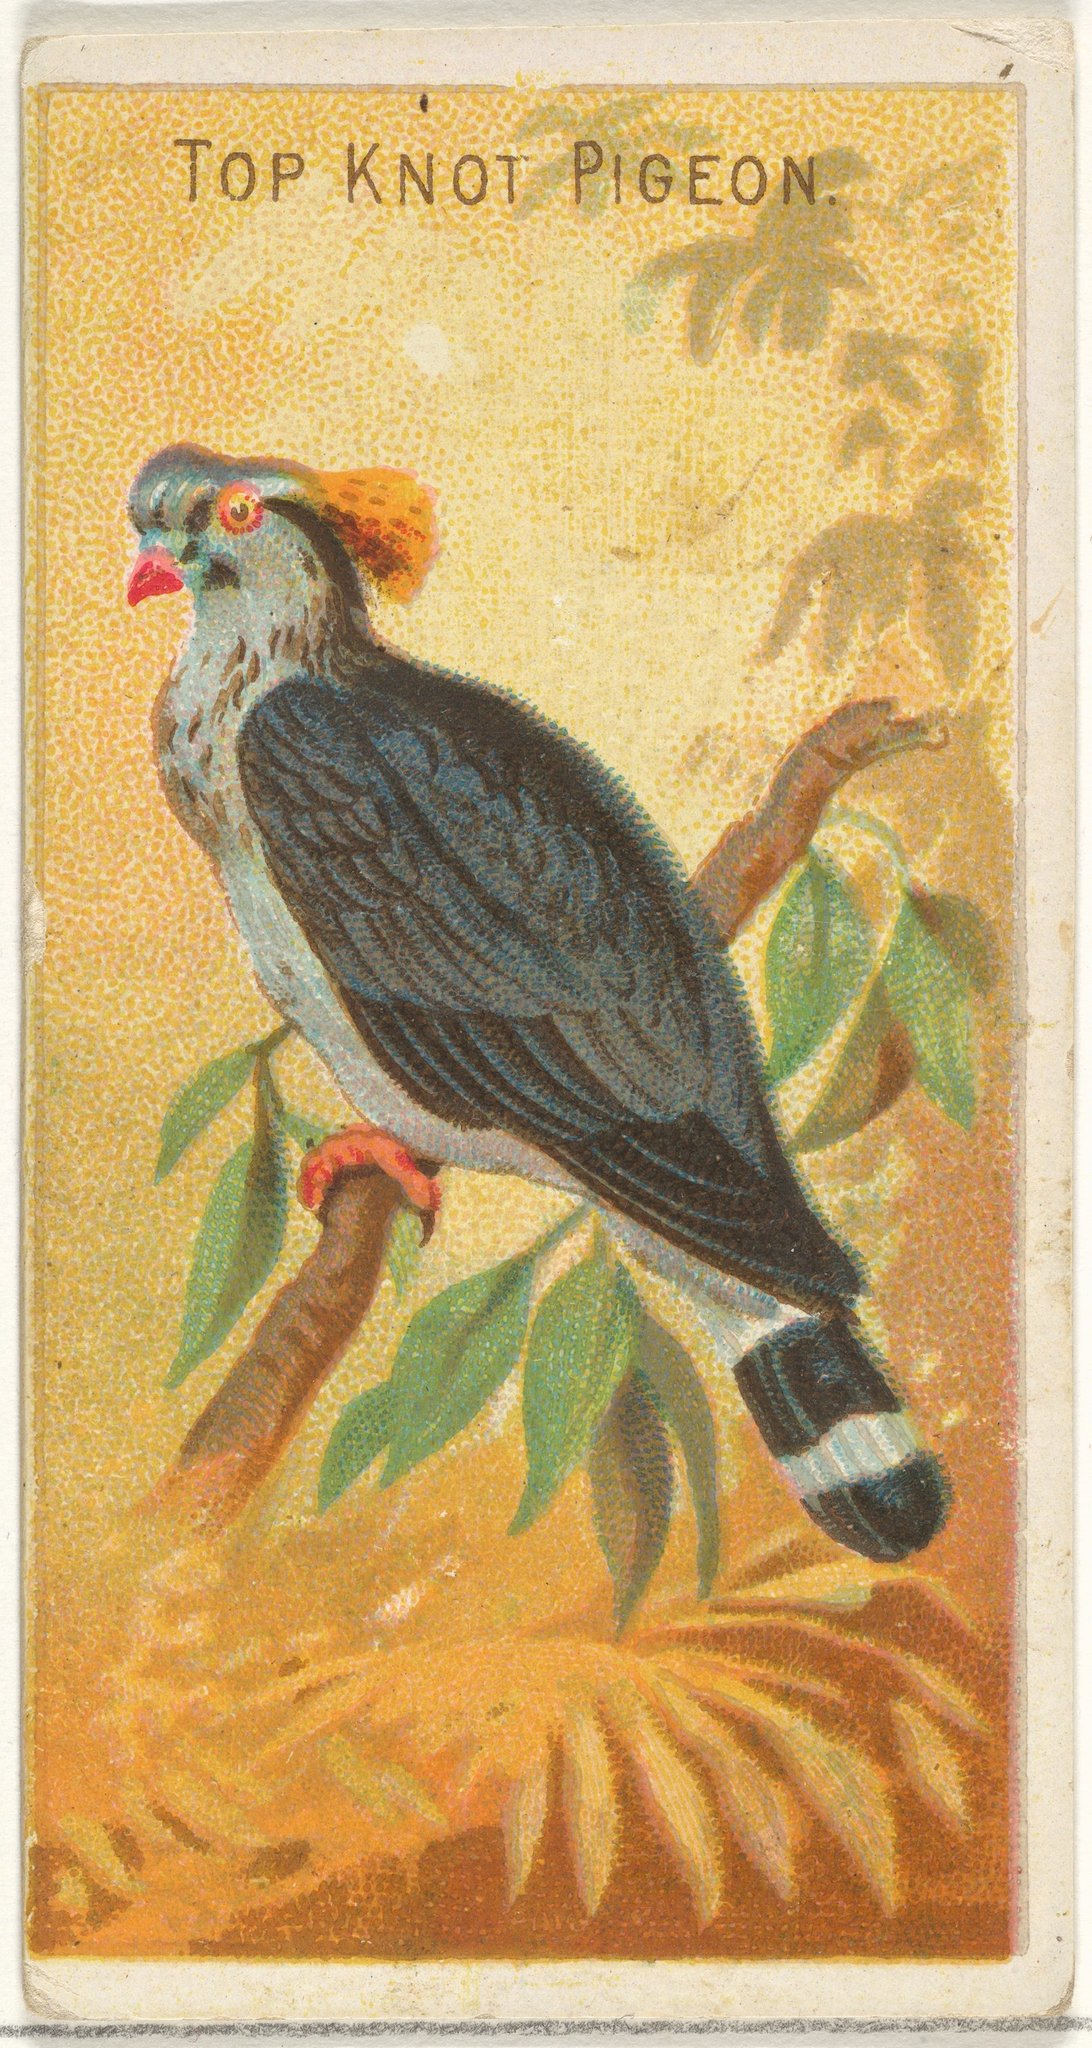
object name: print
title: Top Knot Pigeon, from the Birds of the Tropics series (N5) for Allen & Ginter Cigarettes Brands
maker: allen & ginter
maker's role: publisher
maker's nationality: american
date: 1889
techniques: color lithograph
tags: pigeons